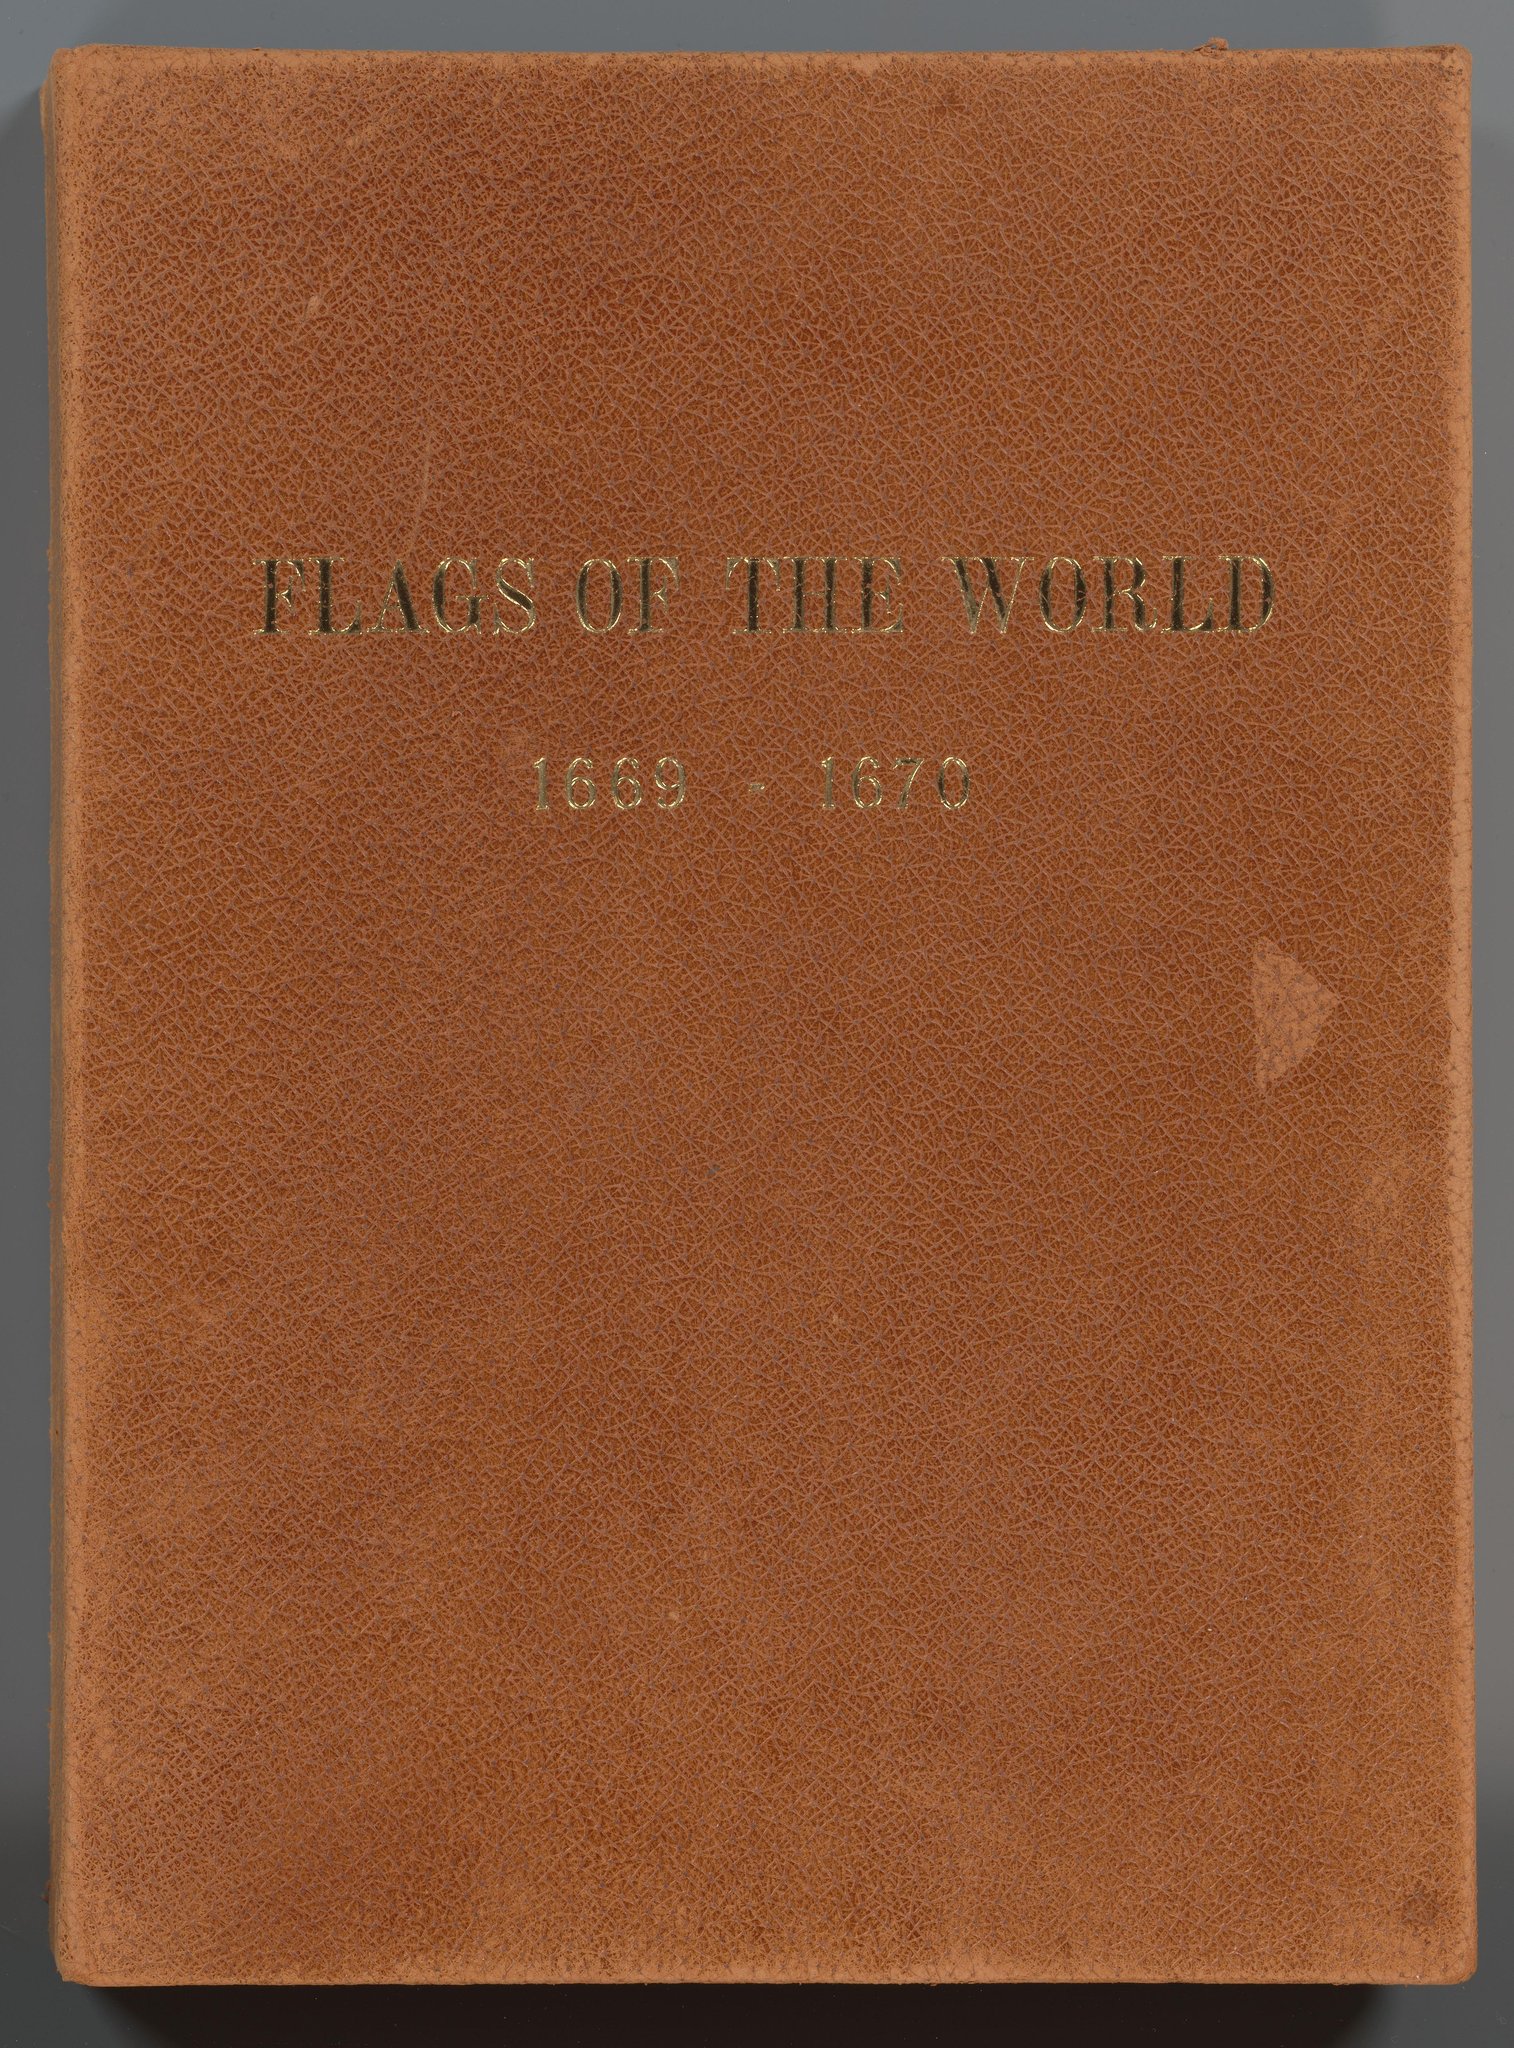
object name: drawing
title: Flag book depicting flags of the world, circa 1669-1670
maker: Anonymous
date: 1667-1670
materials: ink, paper, watercolor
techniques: brush, pen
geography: france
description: Verzameling van tekeningen van 126 vlaggen, meest ingekleurd, enkele met titel (land of stad waarop de vlag betrekking heeft), elk op een eigen blad (in totaal 140 bladen, waaronder enkele blanco). In een latere doos met als titel 'Flags of the world 1669-1670'.